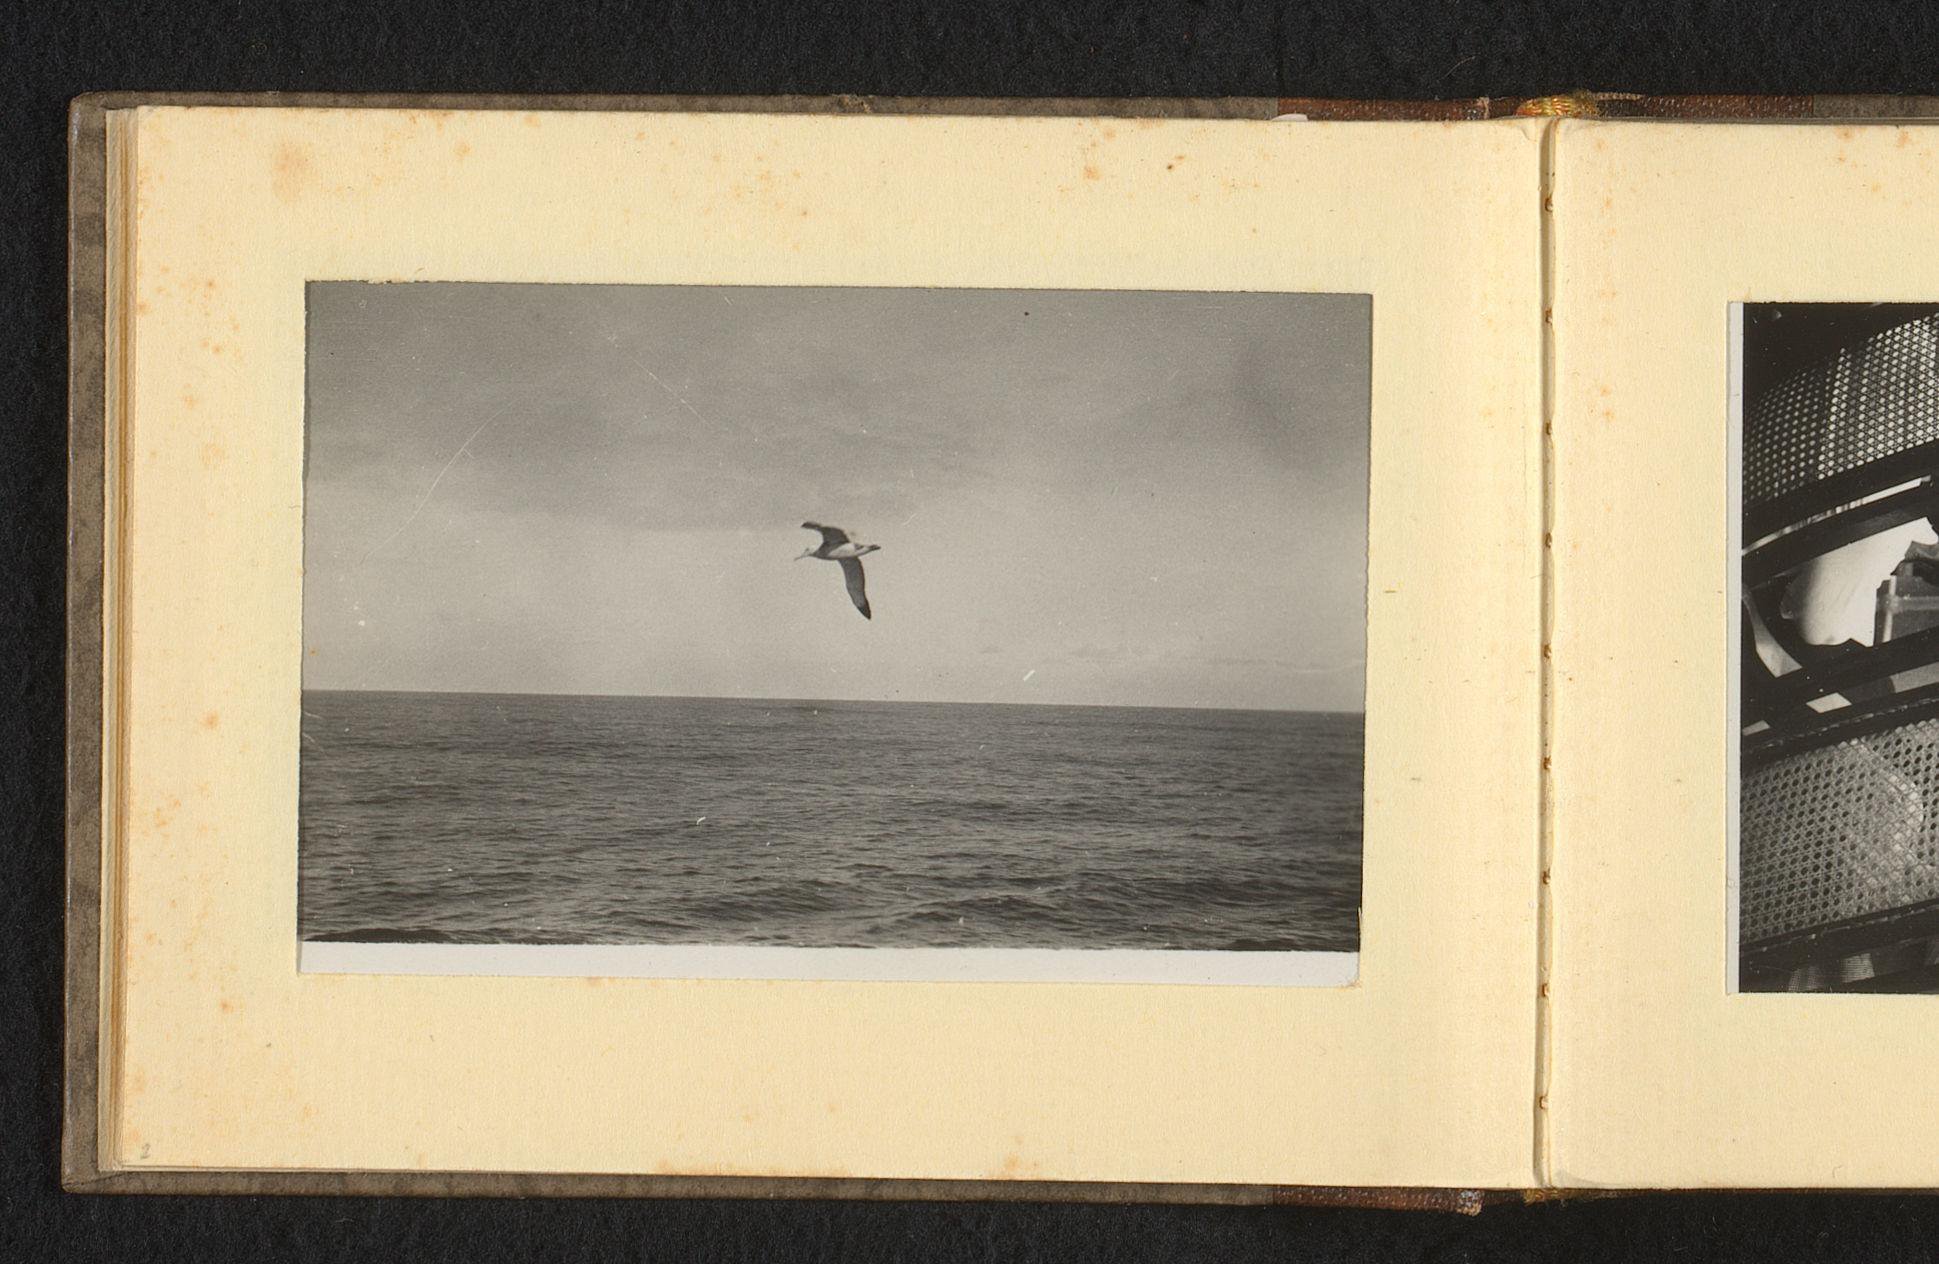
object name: photograph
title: Vliegende meeuw boven een zee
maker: norbert van den berg (1901-1972)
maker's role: amateurfotograaf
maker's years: 1901-1972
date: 1935-1950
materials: paper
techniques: gelatin silver print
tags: shore-birds and wading-birds: gull, sea